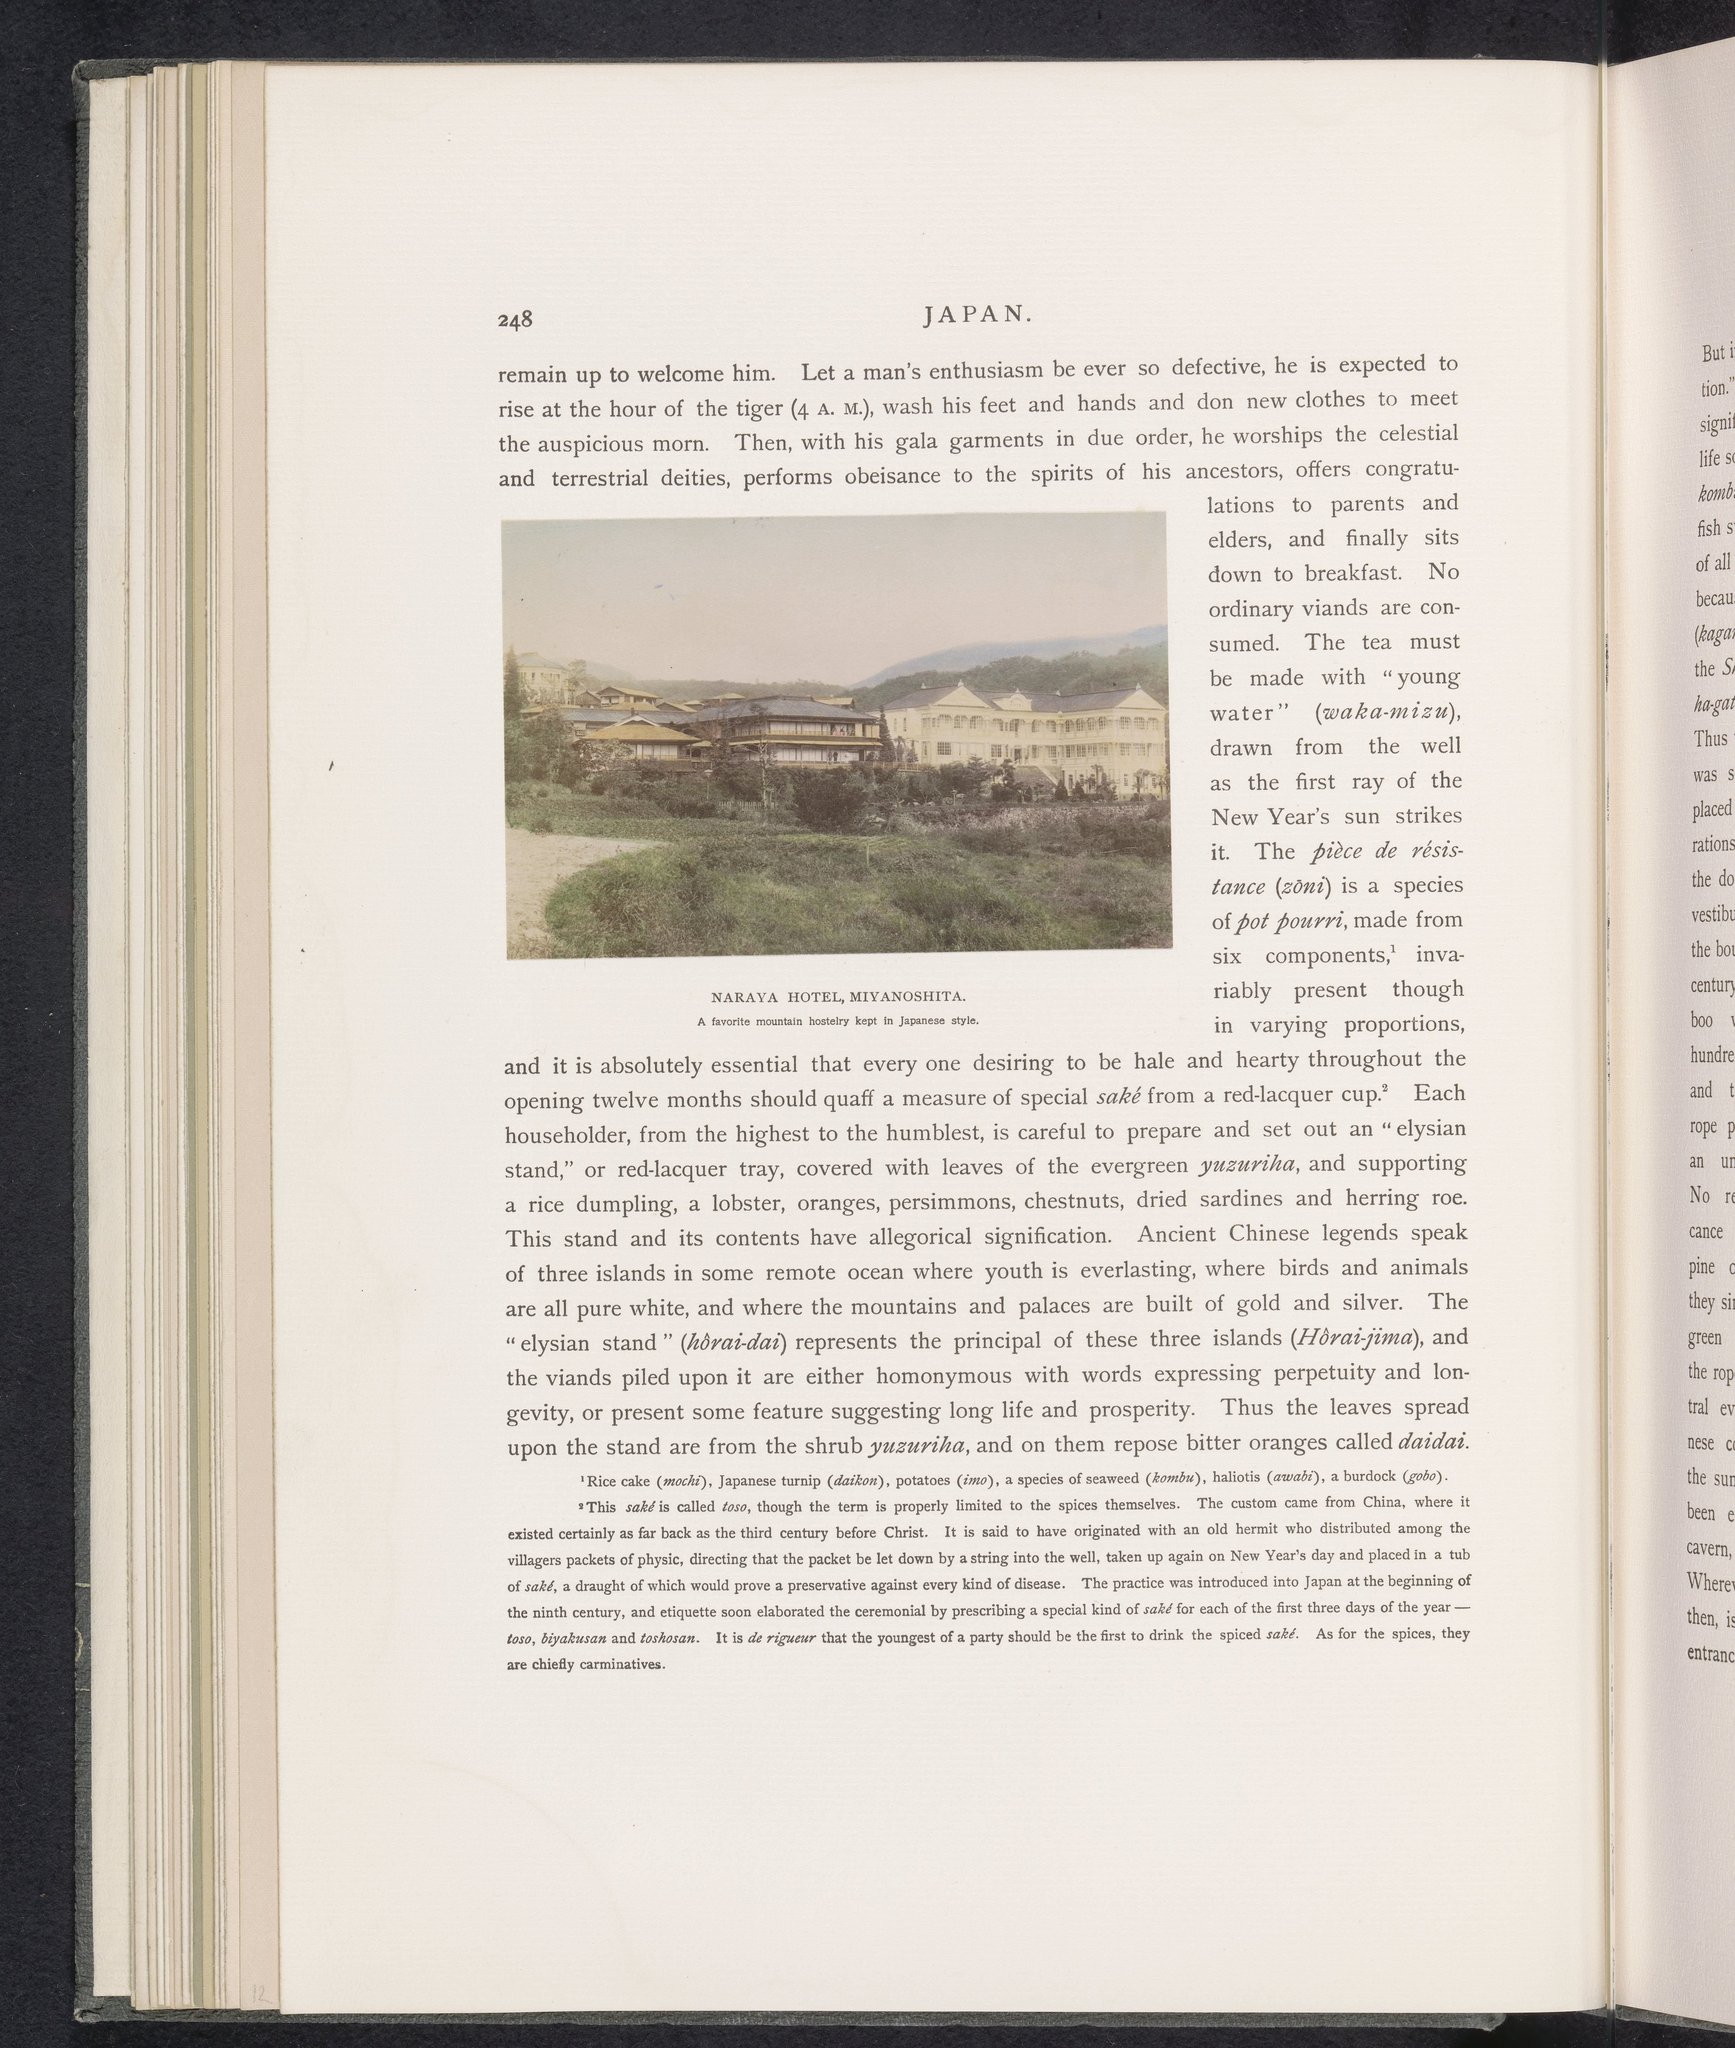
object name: photograph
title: Naraya hotel, Miyanoshita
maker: Anonymous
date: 1887-1897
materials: photographic support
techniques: albumen print, hand coloring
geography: japan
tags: façade (of house or building), hotel, hostelry, inn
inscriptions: inscription: ‘A favorite mountain hostelry kept in Japanese style.’